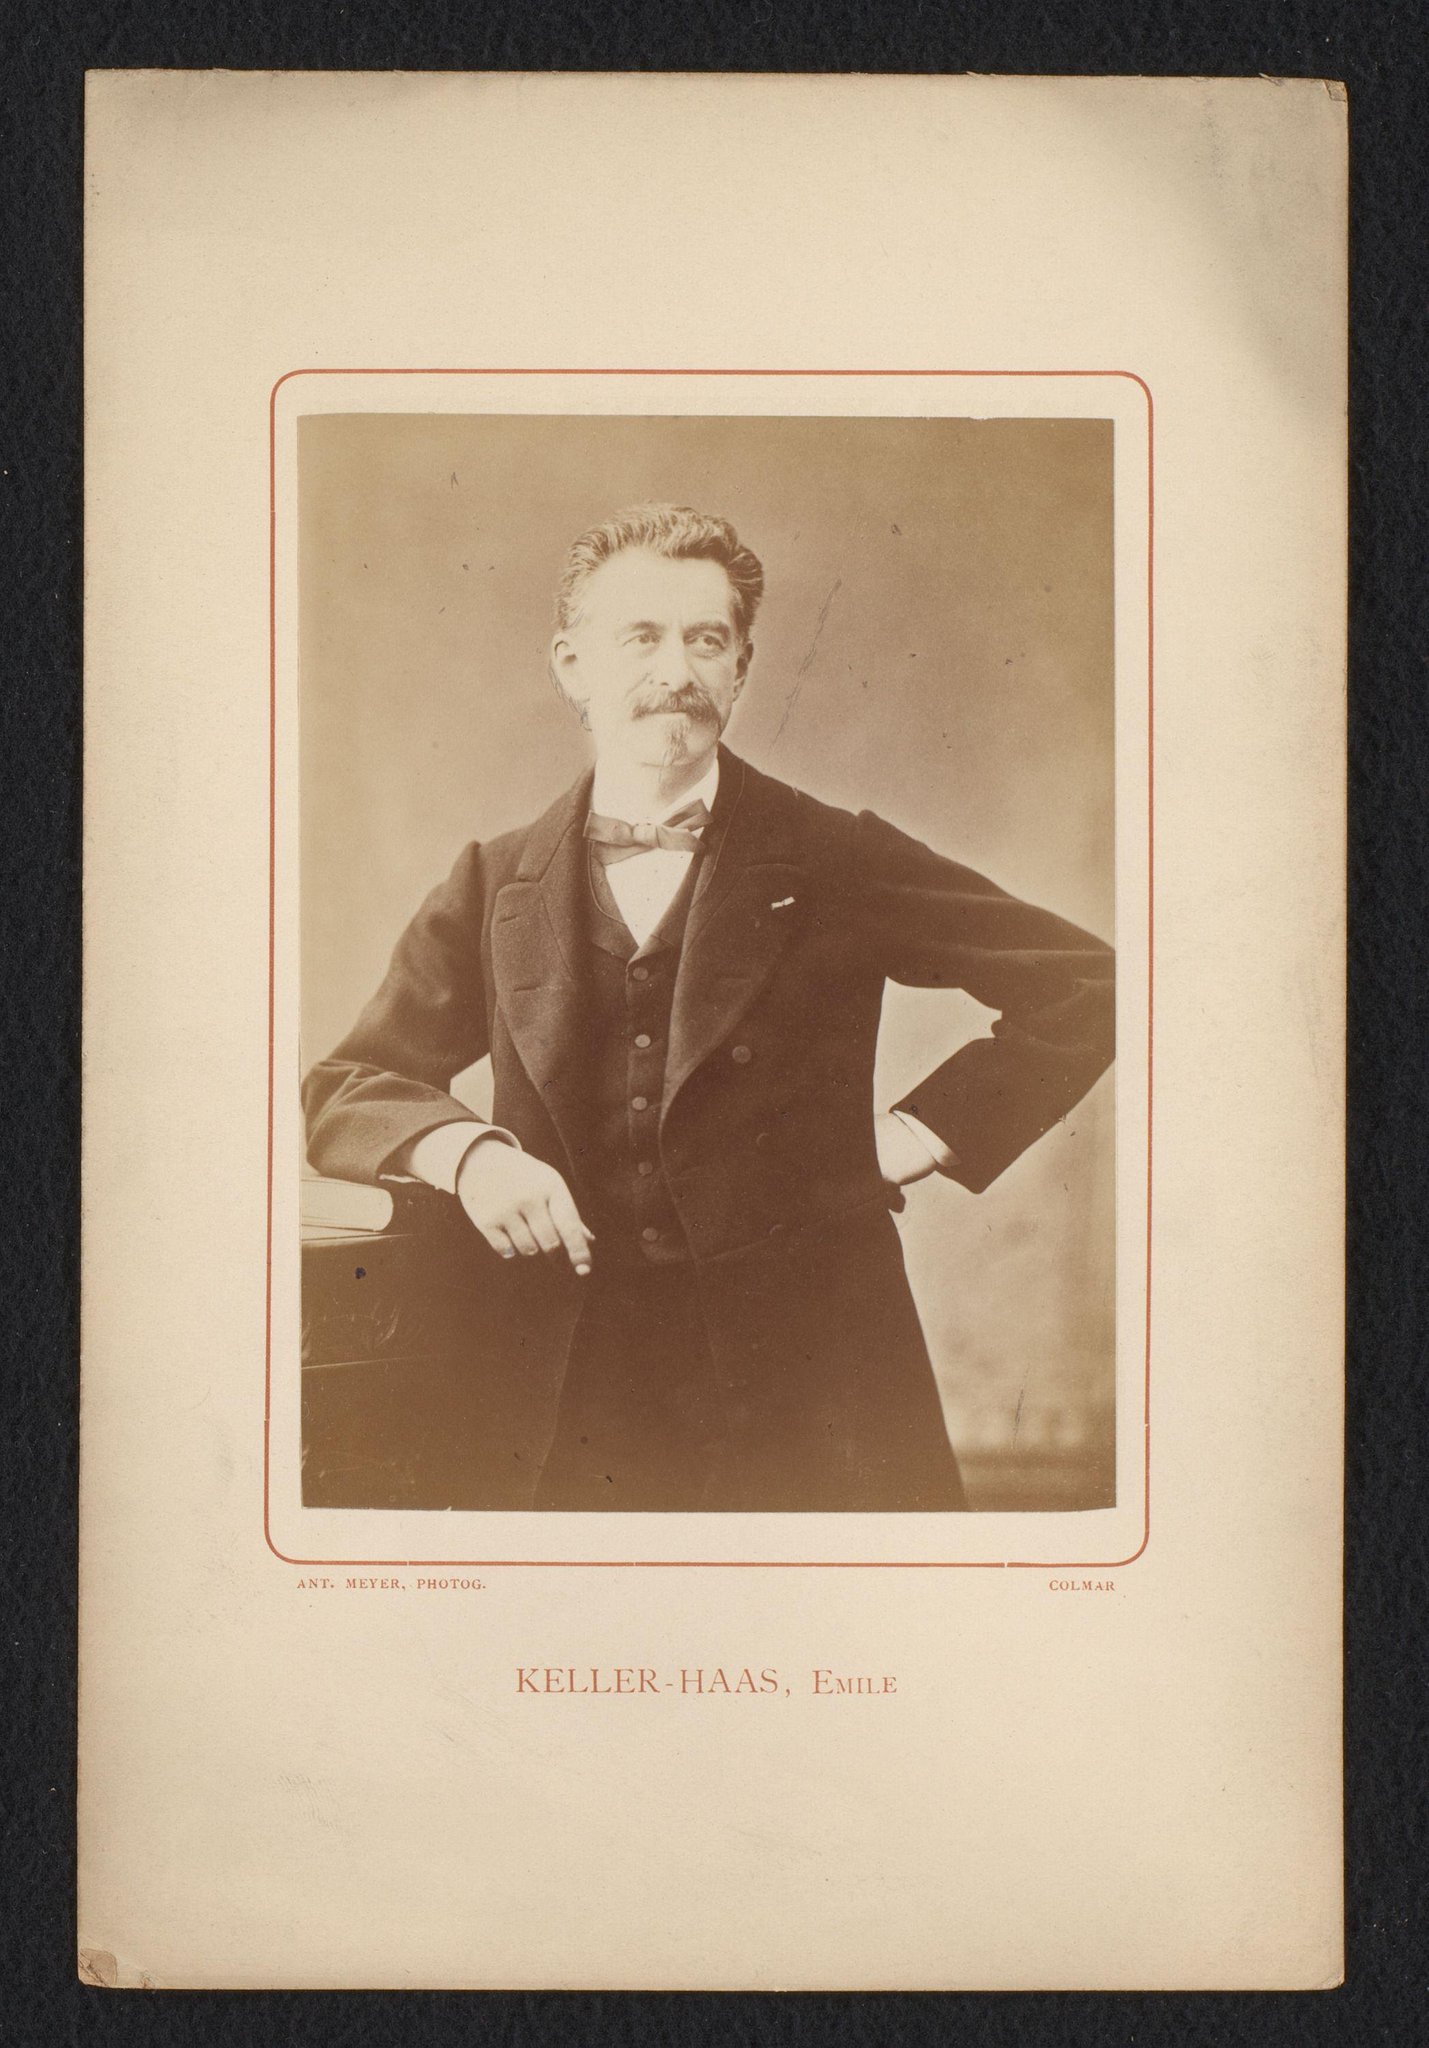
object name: photograph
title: Portret van Emile Keller-Haas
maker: anton meyer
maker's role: fotograaf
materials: photographic support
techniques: albumen print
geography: colmar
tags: paris, politician, historical persons, portrait of a writer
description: Deze foto maakt deel uit van een omslag met 29 foto's op 29 bladen en 23 teksbladen.